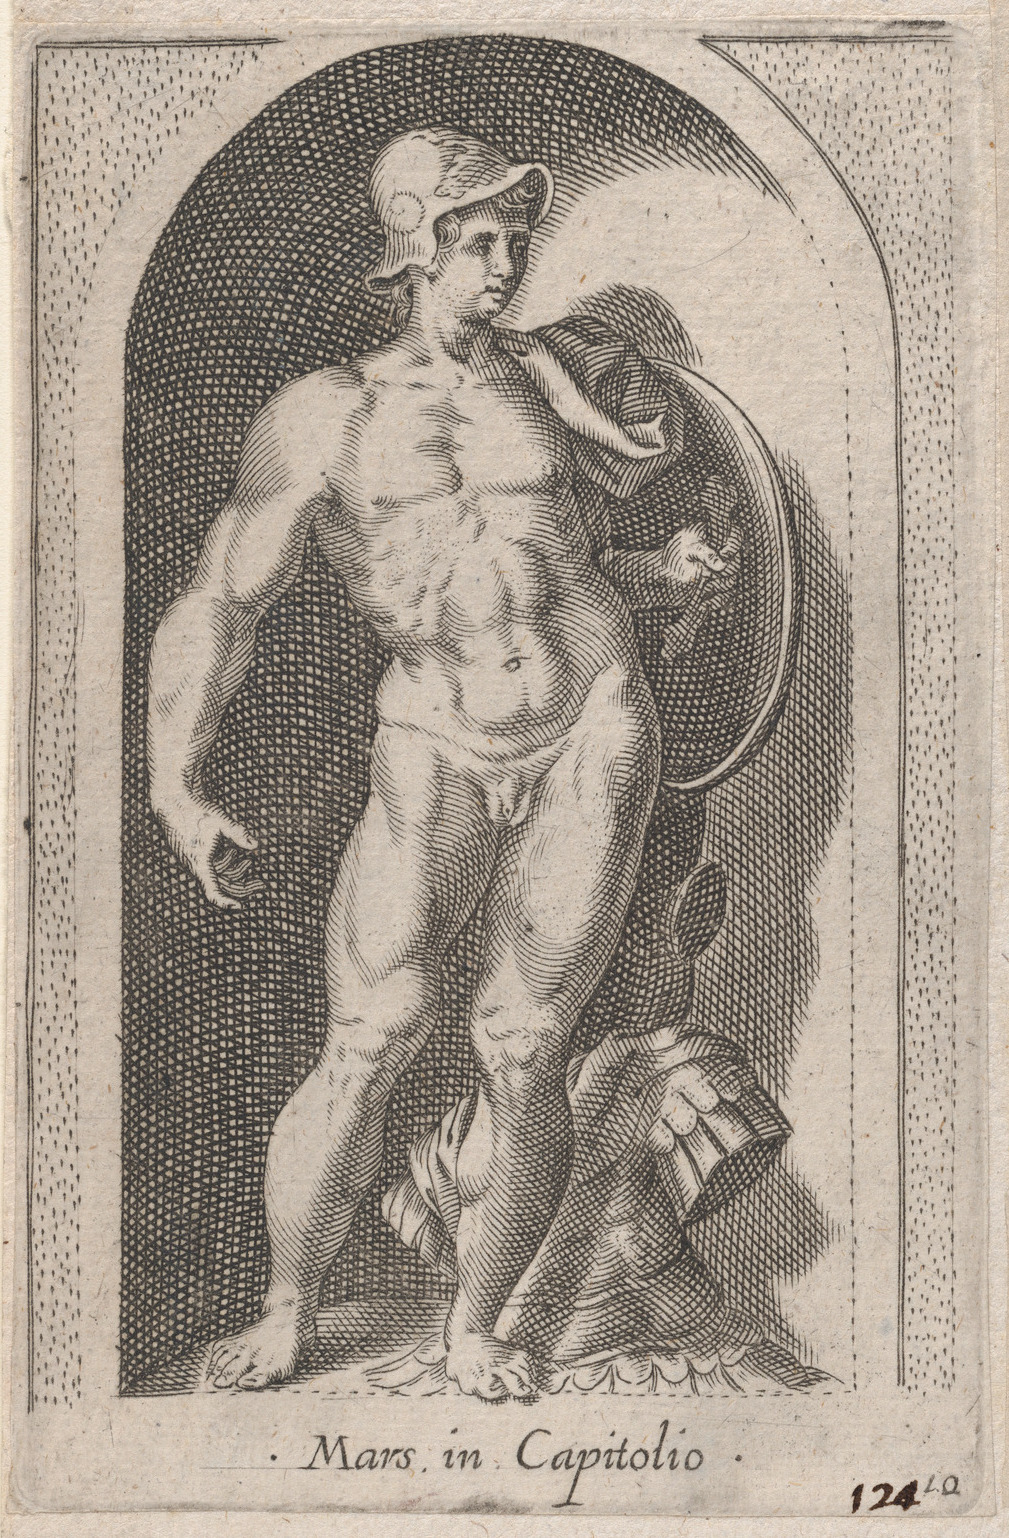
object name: print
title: Mars (Mars in Capitolio), from "Speculum Romanae Magnificentiae"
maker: Anonymous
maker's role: artist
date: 1501-1600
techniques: engraving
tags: mars